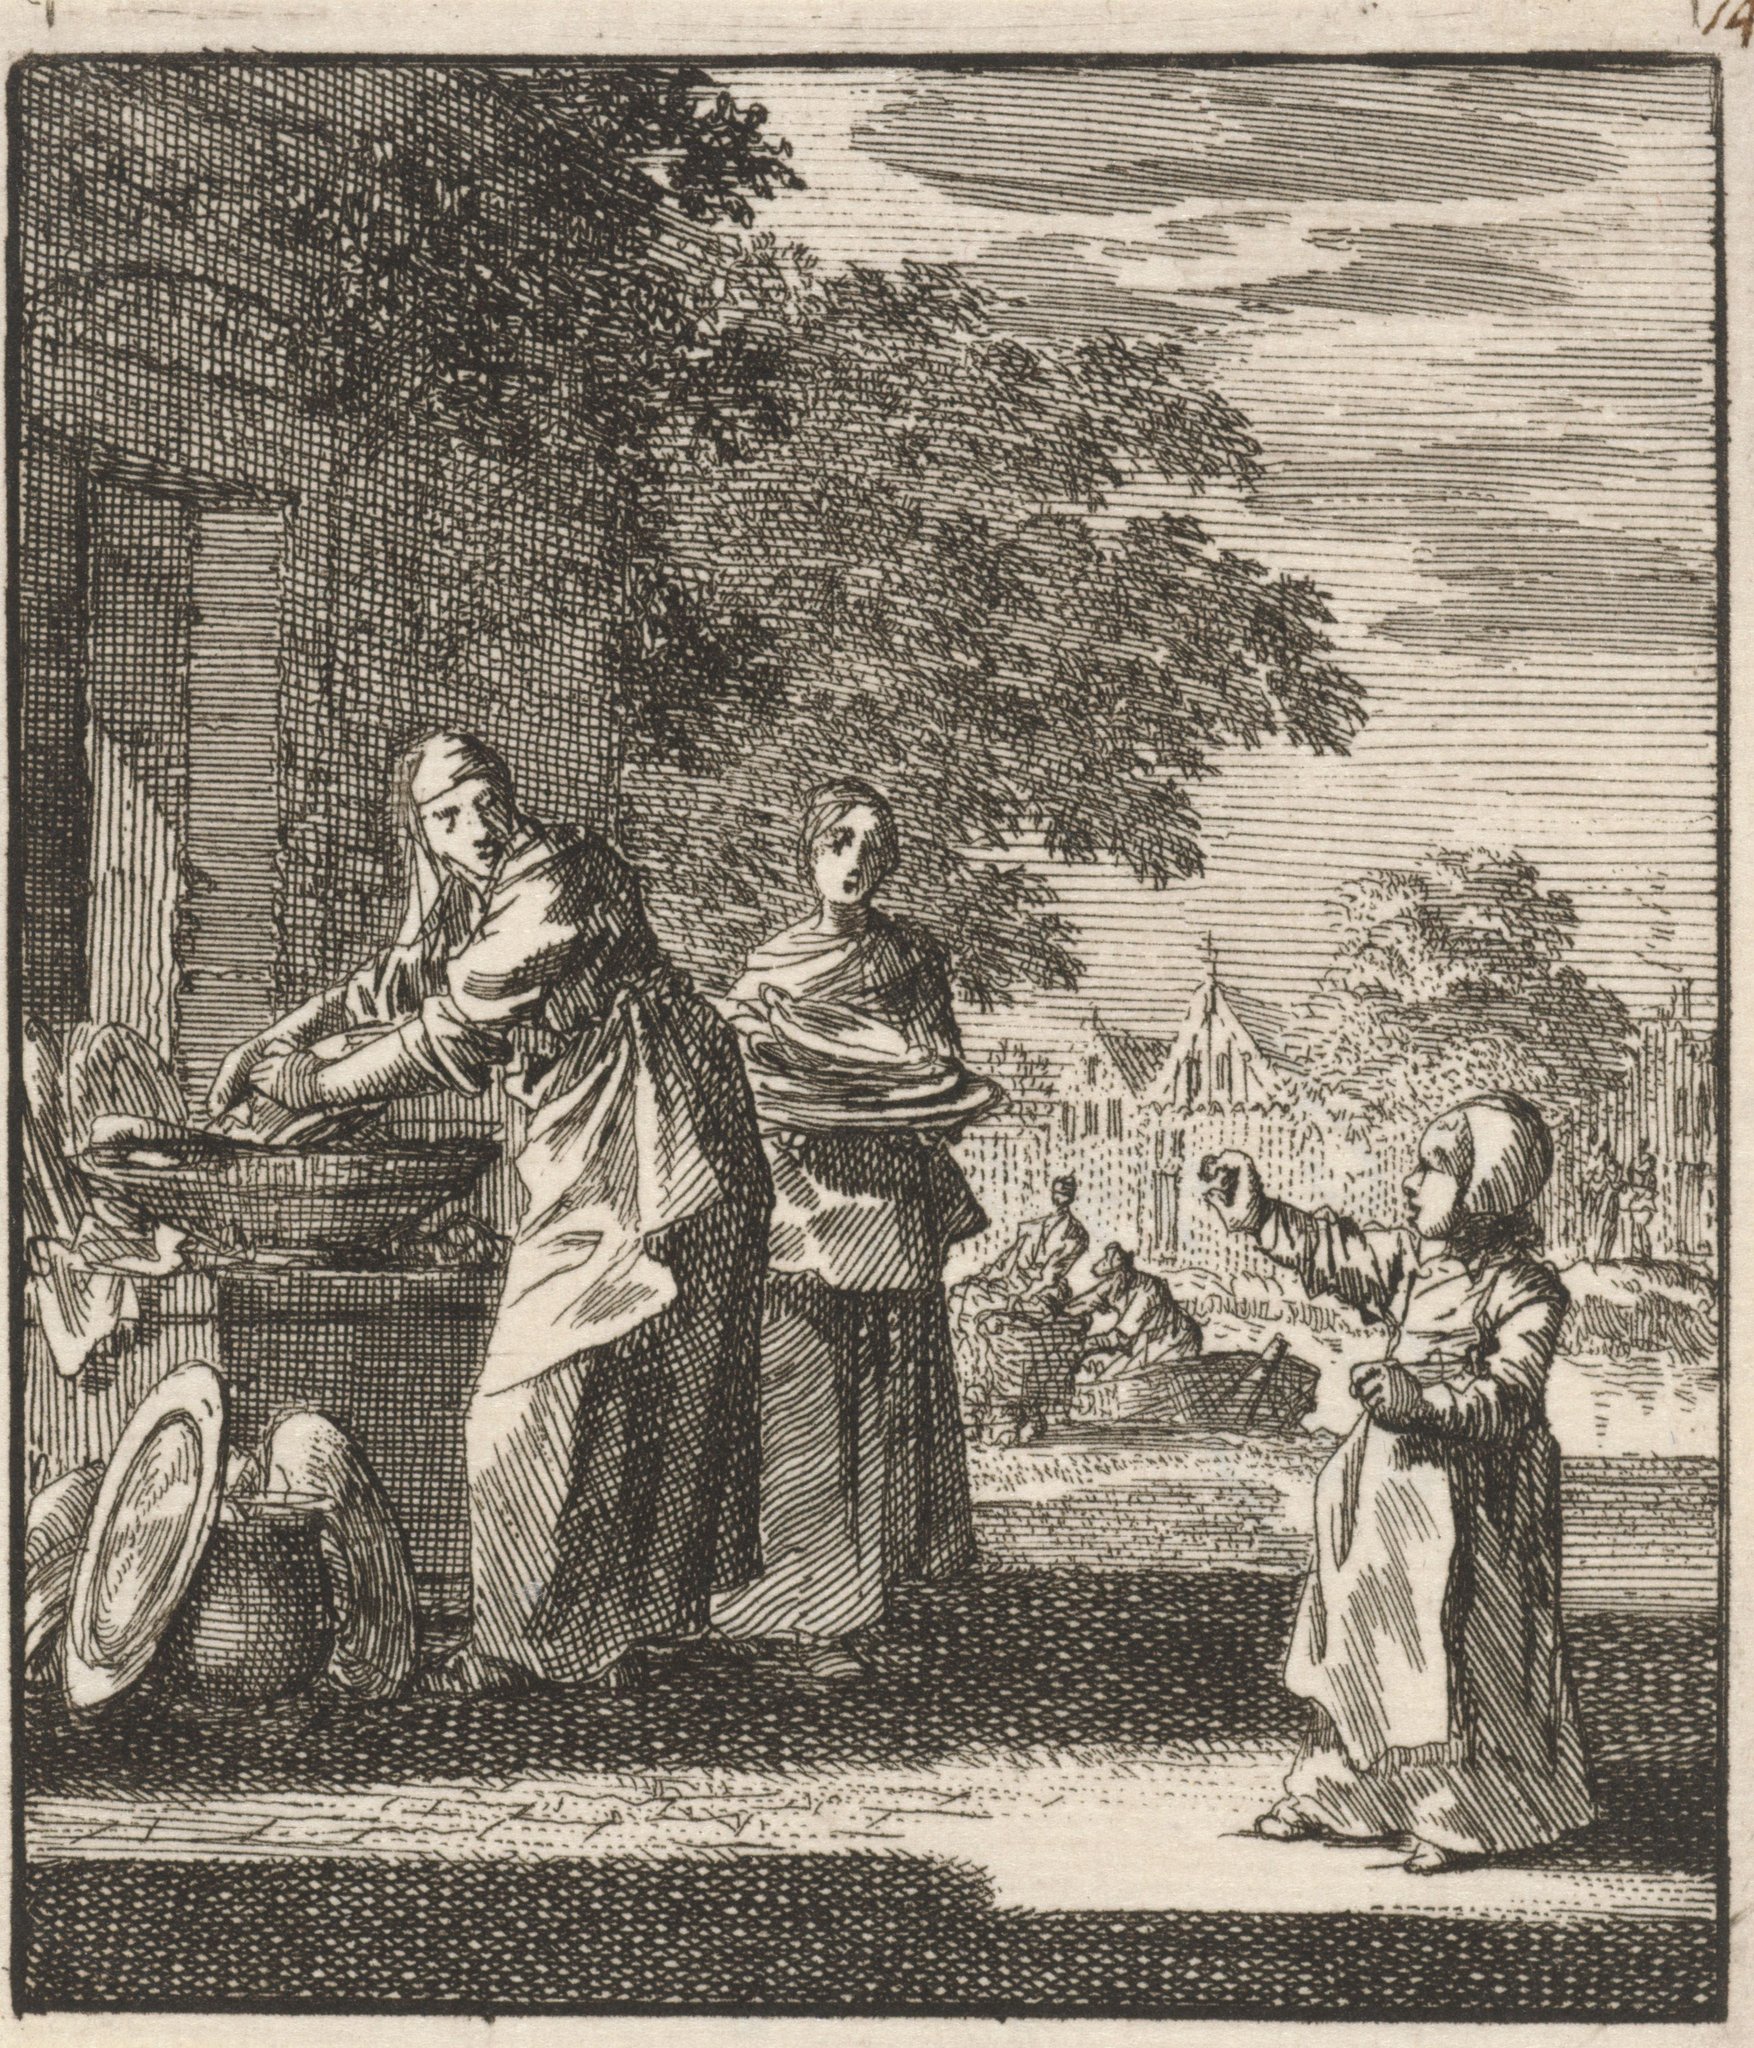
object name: print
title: Kind roept haar moeder die bezig is met het wassen van vaatwerk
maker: jan luyken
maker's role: draughtsman, print maker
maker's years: 1649-1712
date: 1712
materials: paper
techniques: etching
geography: amsterdam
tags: mother and baby or young child, washing up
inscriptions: collector's mark: Lugt 2228, number: ‘14’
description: Proefdruk van illustratie uit: Luyken, Jan. Des menschen begin, midden en einde. Amsterdam: Wed. Pieter Arentsz II en Cornelis van der Sys, 1712, p. 29.